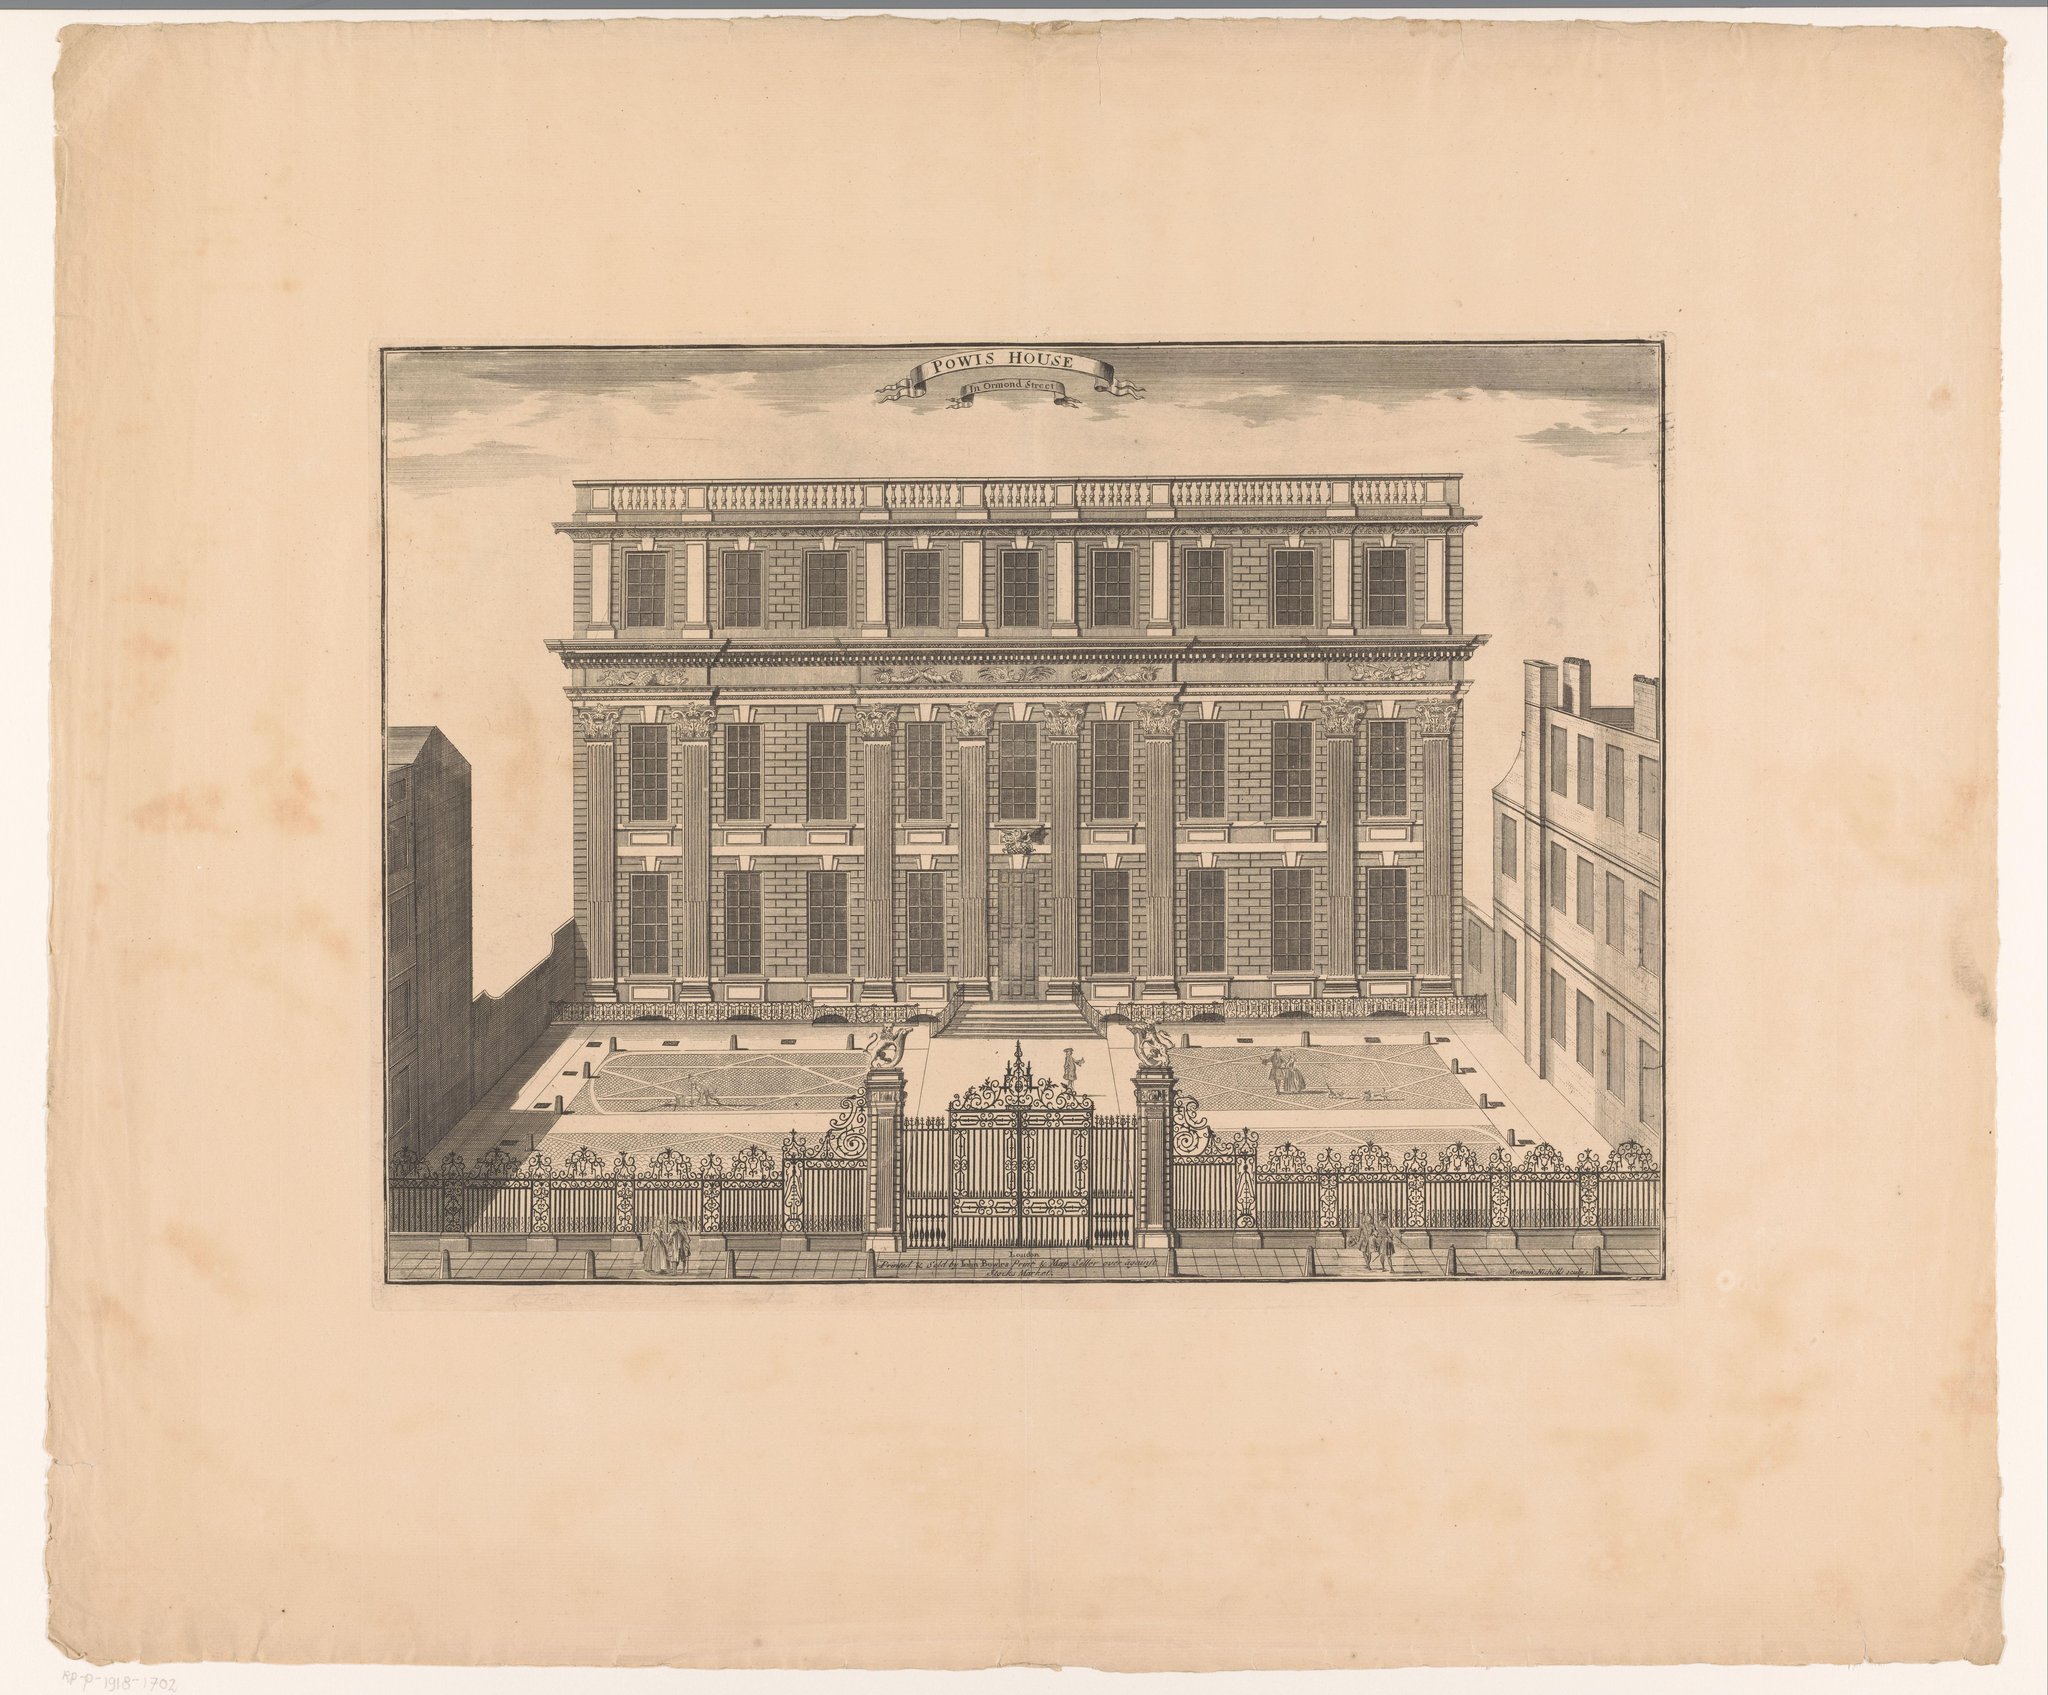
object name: print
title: Gezichten op gebouwen in Londen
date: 1720-1731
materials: paper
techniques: engraving, etching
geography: london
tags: hôtel, i.e. small palace in city, london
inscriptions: collector's mark: Lugt 2233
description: Deze reeks werd voor het eerst compleet uitgegeven in 1731, al zijn de losse prenten al voor die tijd uitgebracht. De meeste prenten zijn vervaardigd door Sutton Nicholls. De serie werd aangeboden voor verkoop door John Bowles in zijn catalogus 1753, op pagina 76, nummer 16.